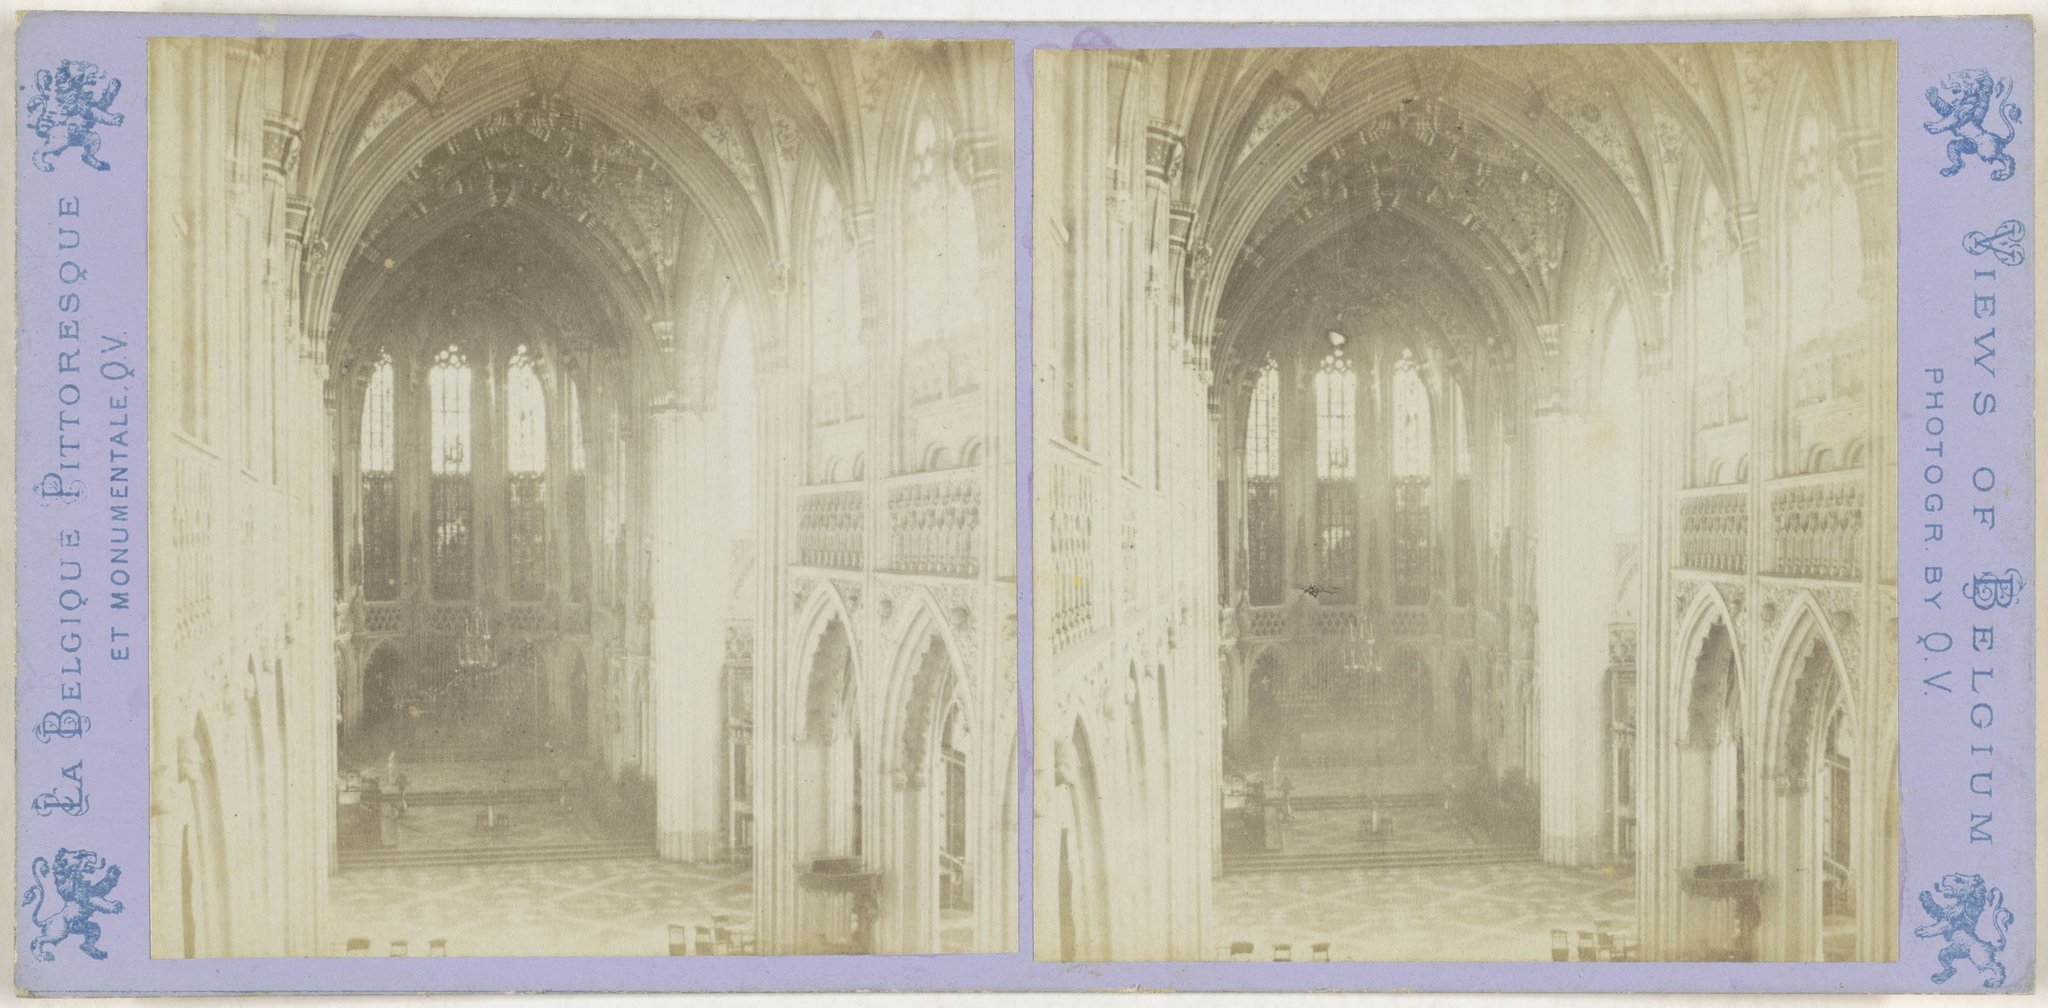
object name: stereograph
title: La Belgique pittoresque et monumentale / Views of Belgium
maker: jules hippolyte quéval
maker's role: publisher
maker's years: 1824-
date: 1866-1870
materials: cardboard, paper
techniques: albumen print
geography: liège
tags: interior of church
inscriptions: number: ‘No 1762’